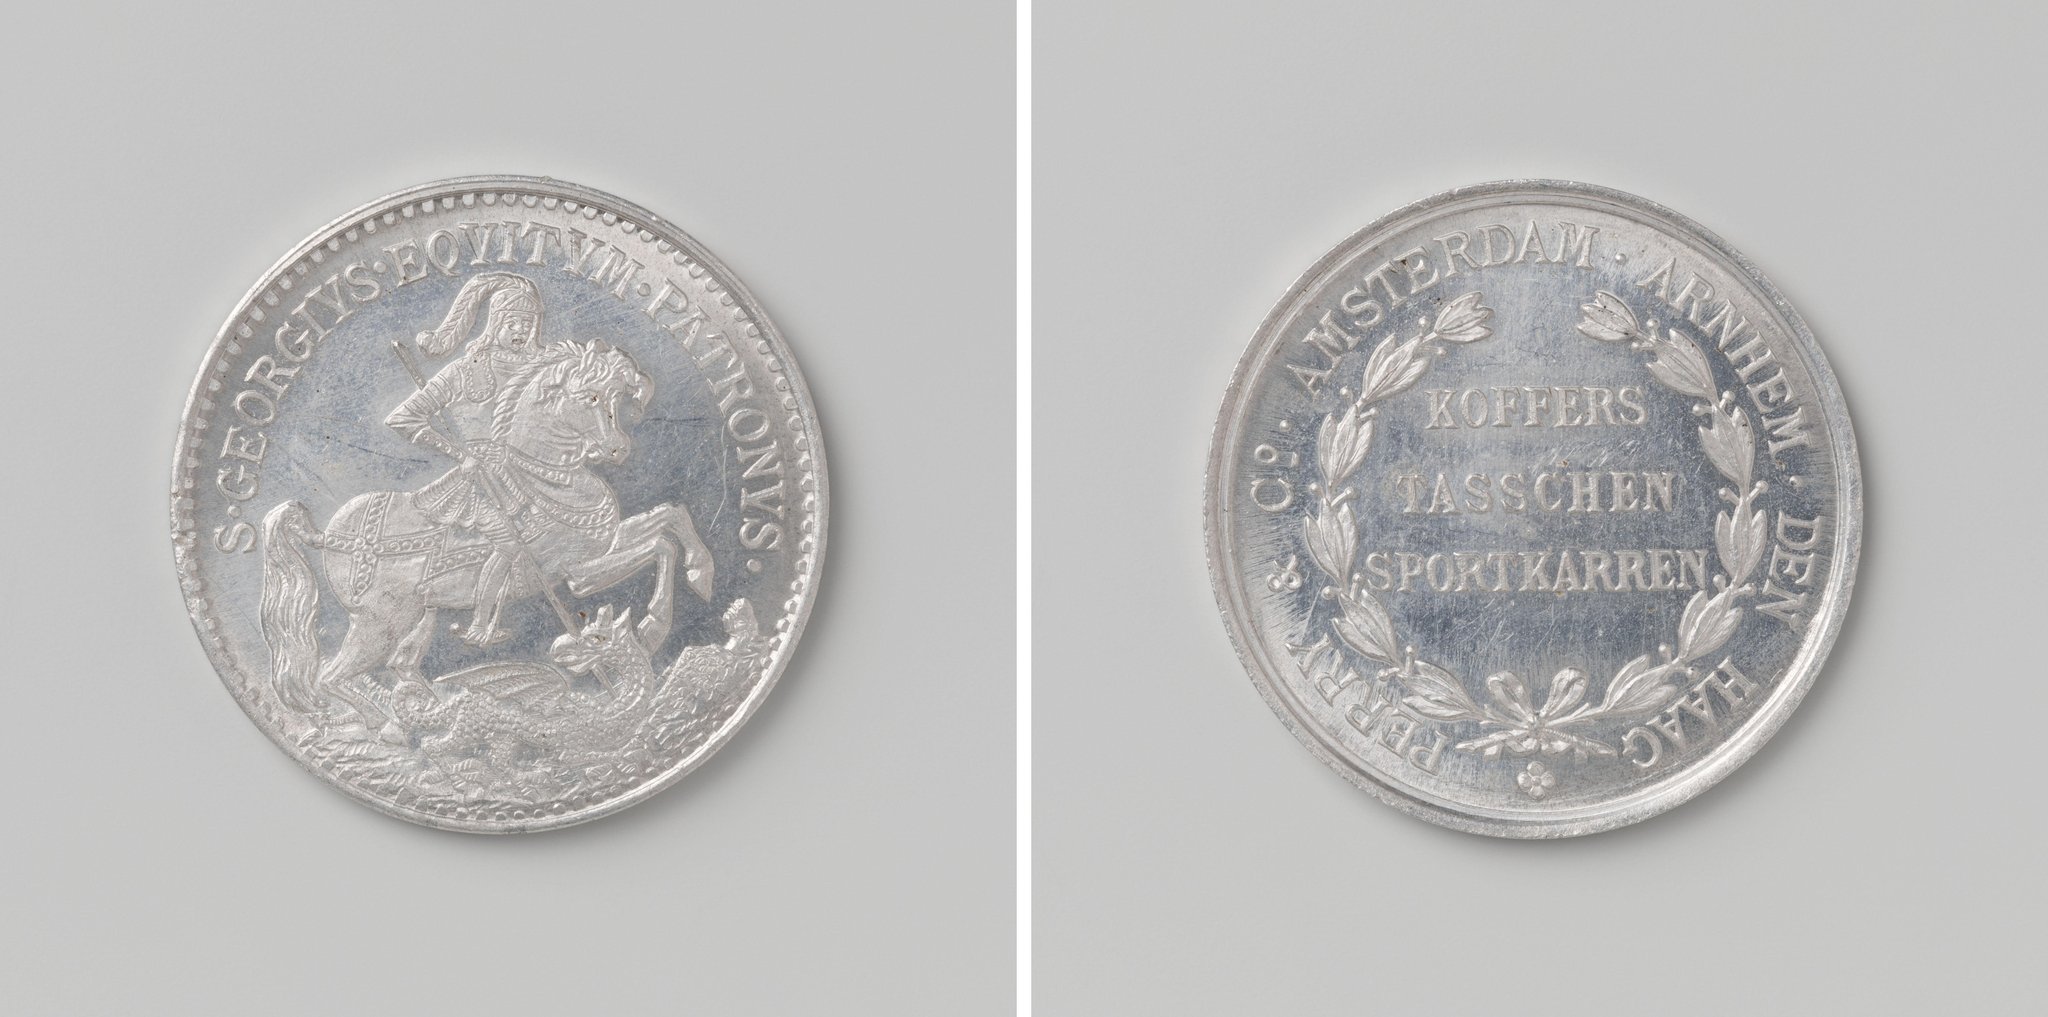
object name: adrespenning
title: Perry & Co. koffers, tassen en sportkarren te Amsteram, Arnhem en 's-Gravenhage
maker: Anonymous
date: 1866-1885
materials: aluminum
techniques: striking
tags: the hague, amsterdam, arnhem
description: Voorzijde: gehelmde Gregorius te paard, rijdend naar rechts doorboort met lans ter aarde liggende draak binnen omschrift. Keerzijde: opschrift binnen krans van myrtebladeren en omschrift